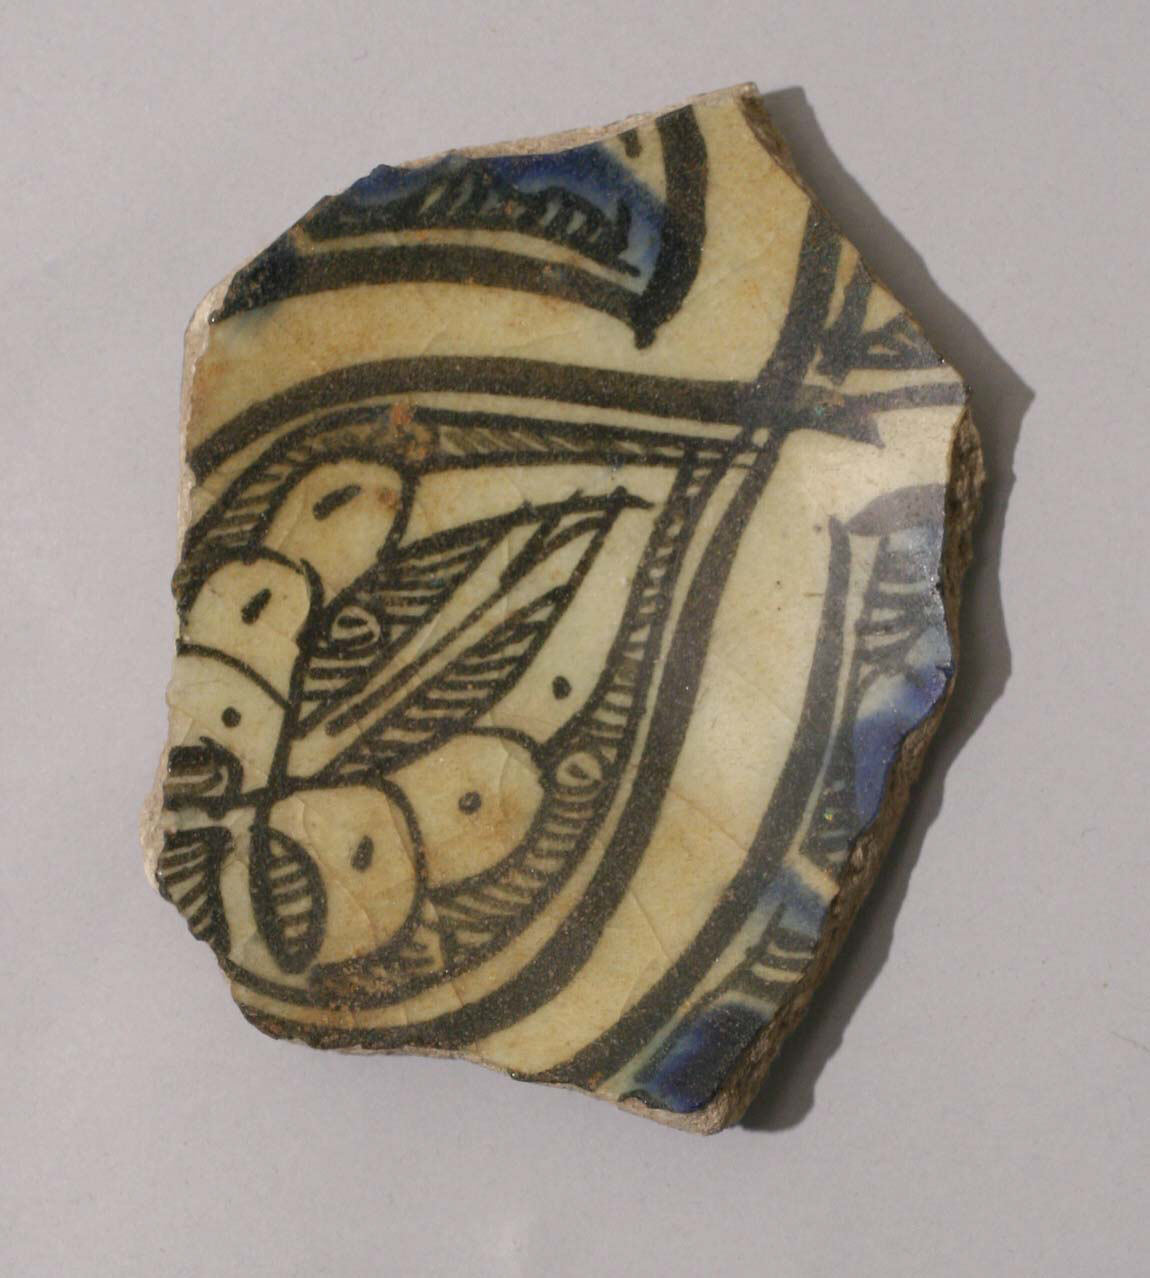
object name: ceramic fragment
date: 1301-1400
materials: glaze, stonepaste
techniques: painting, polychrome, underglaze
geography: syria